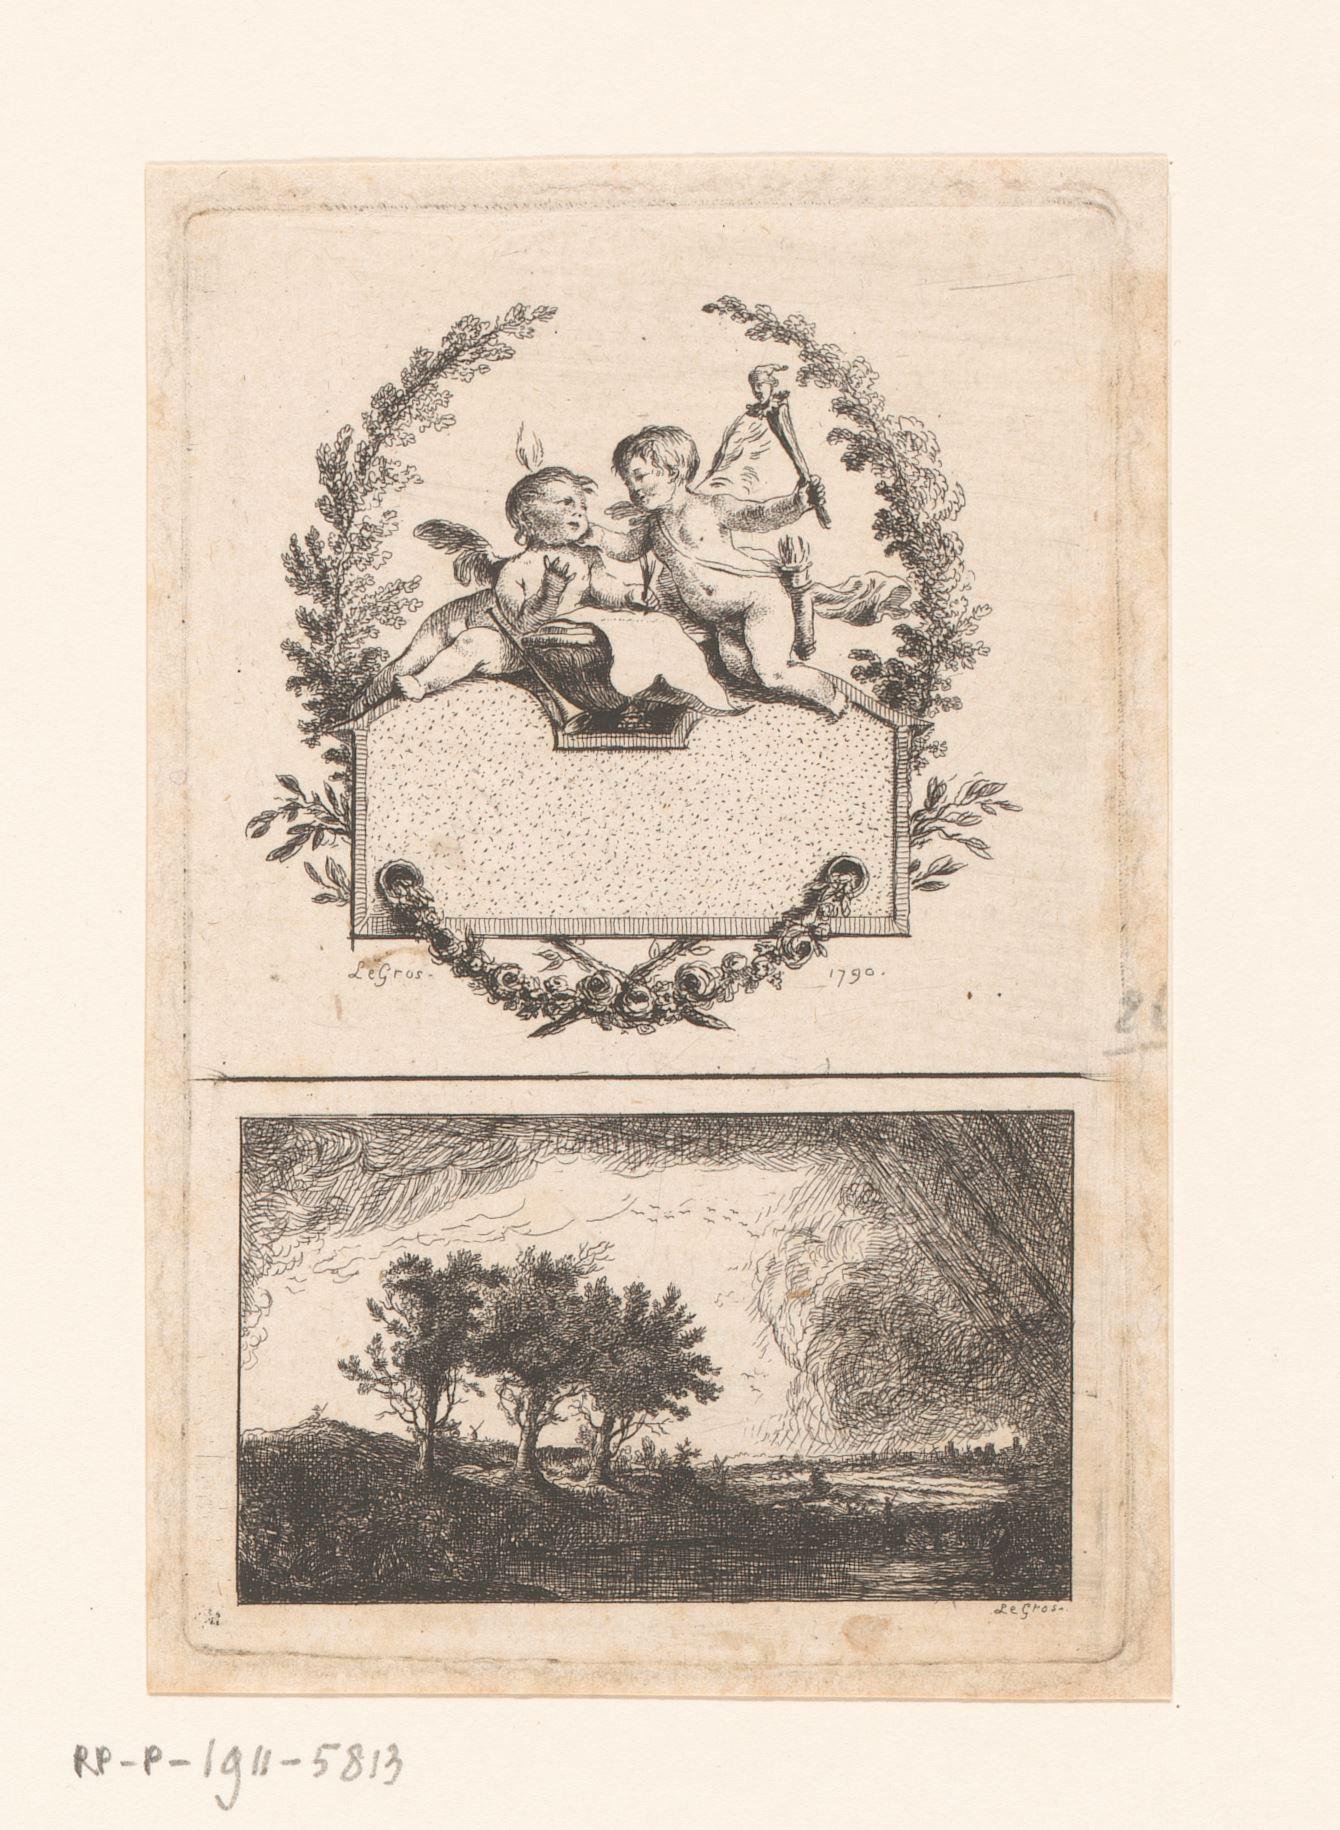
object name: print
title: Twee putti in een guirlande en de drie bomen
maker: sauveur legros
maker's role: print maker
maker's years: 1754-1834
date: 1764-1834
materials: paper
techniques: etching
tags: trees, cupids: 'amores', 'amoretti', 'putti'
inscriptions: collector's mark: Lugt 2228